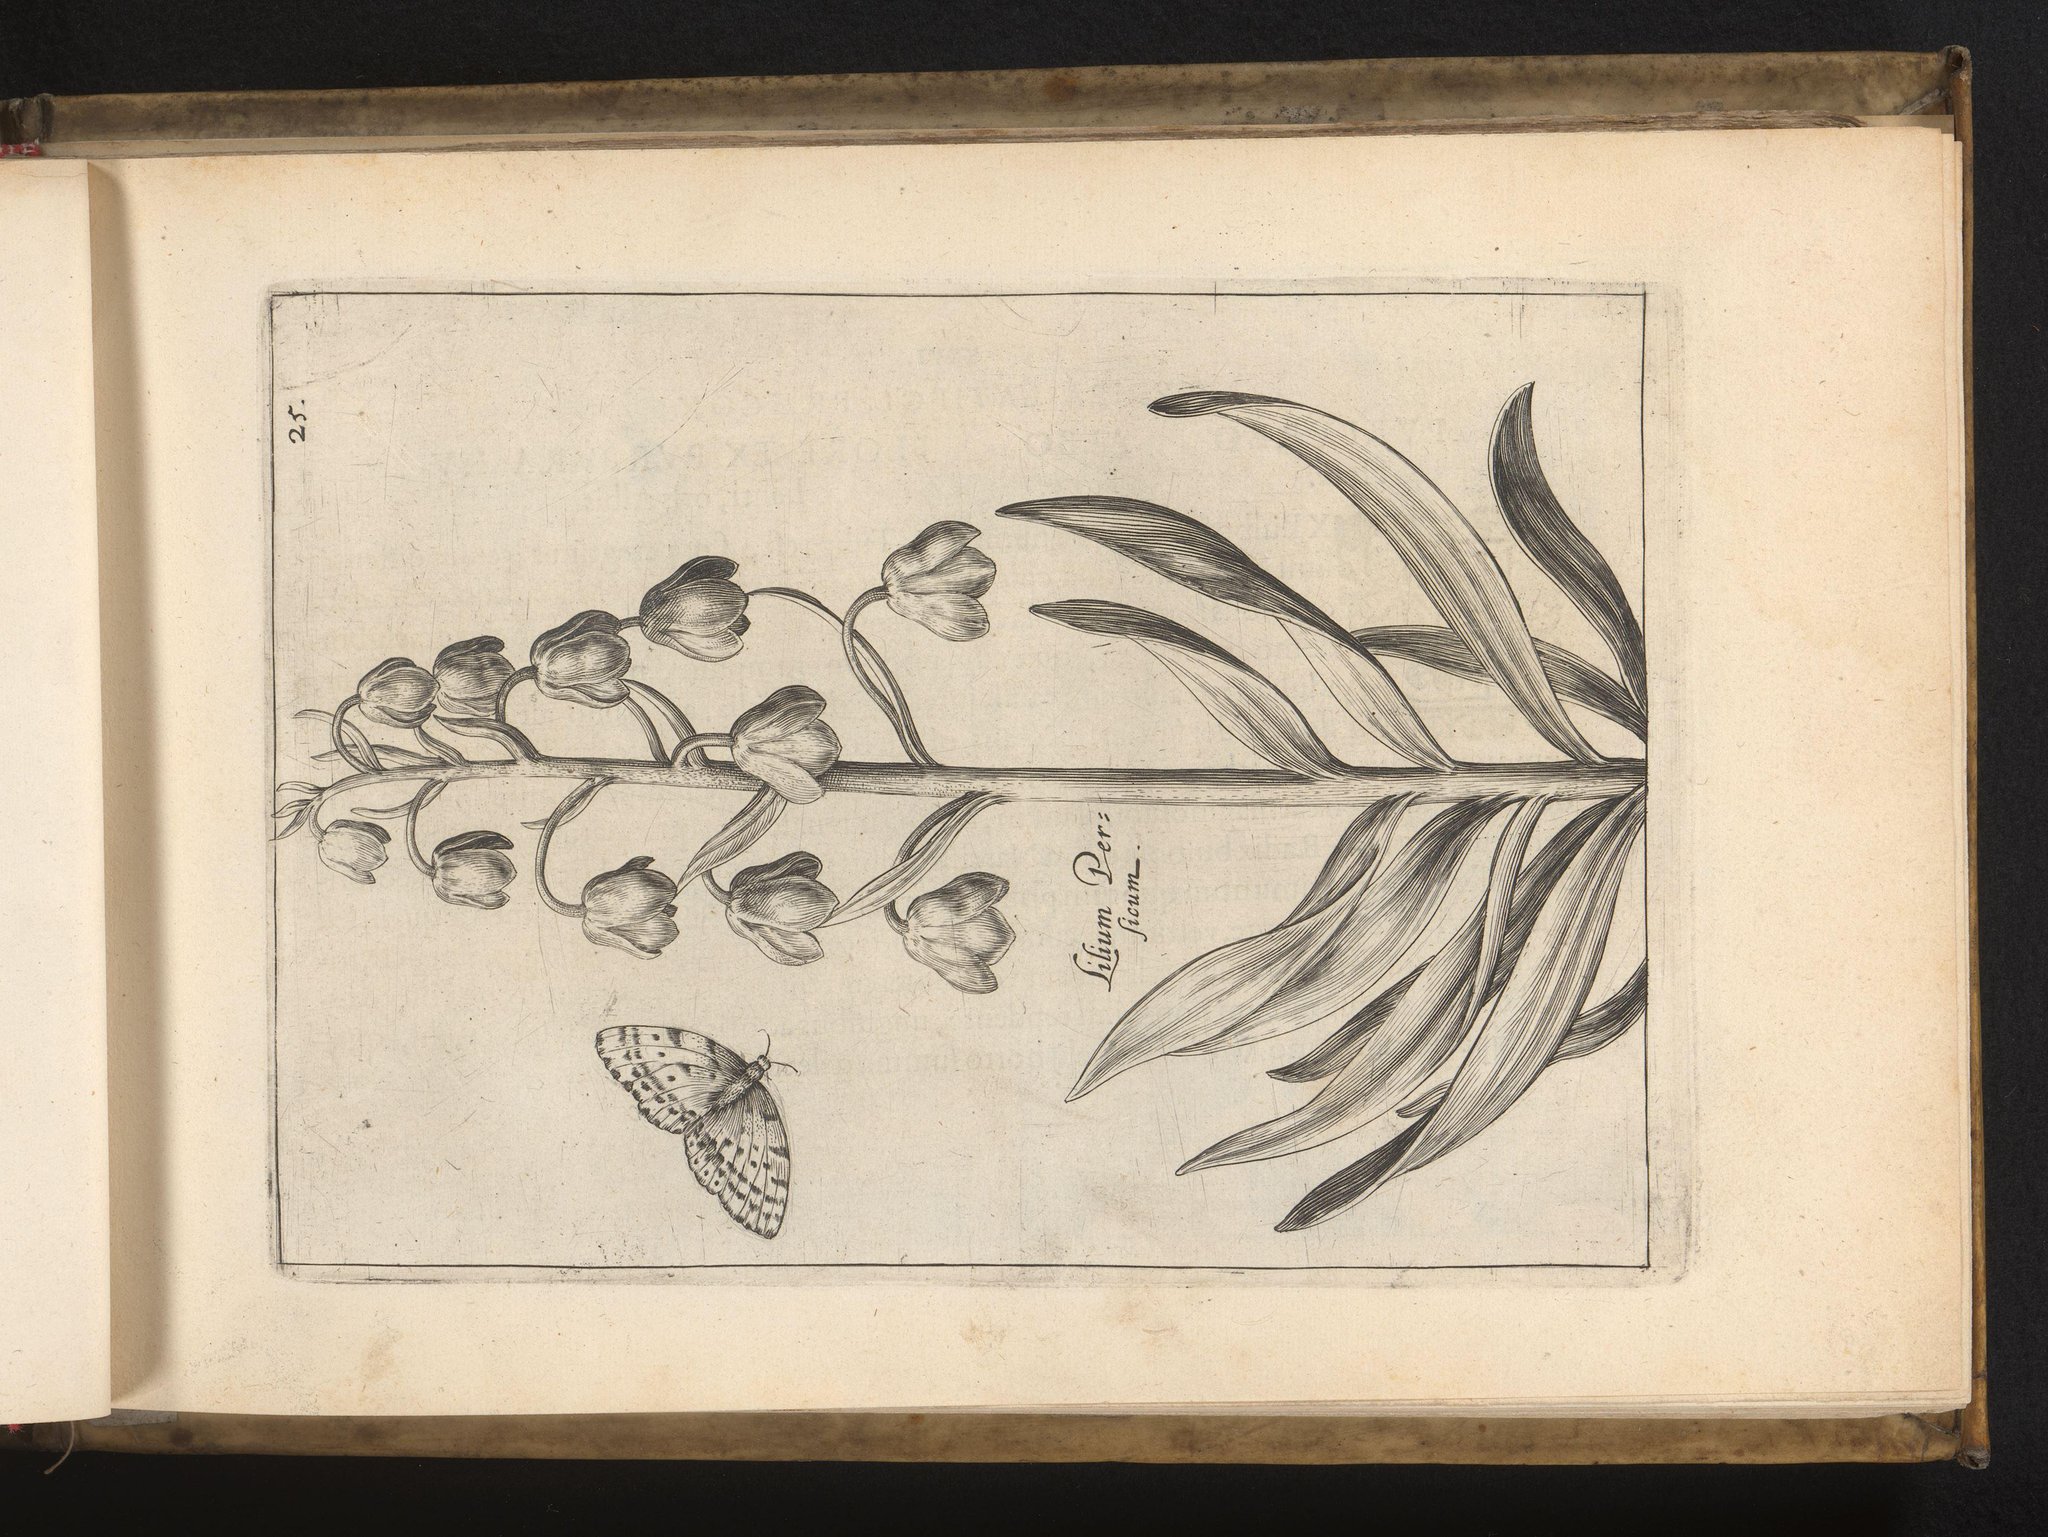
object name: book illustration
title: Hortus floridus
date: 1617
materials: paper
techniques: engraving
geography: utrecht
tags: flowers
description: Prent uit: Passe, Crispijn van de (II). Hortus floridus in quo rariorum & minus vulgarium florum icones ad vivam veramque formam. Arnhem: Johannes Janssonius, 1617.